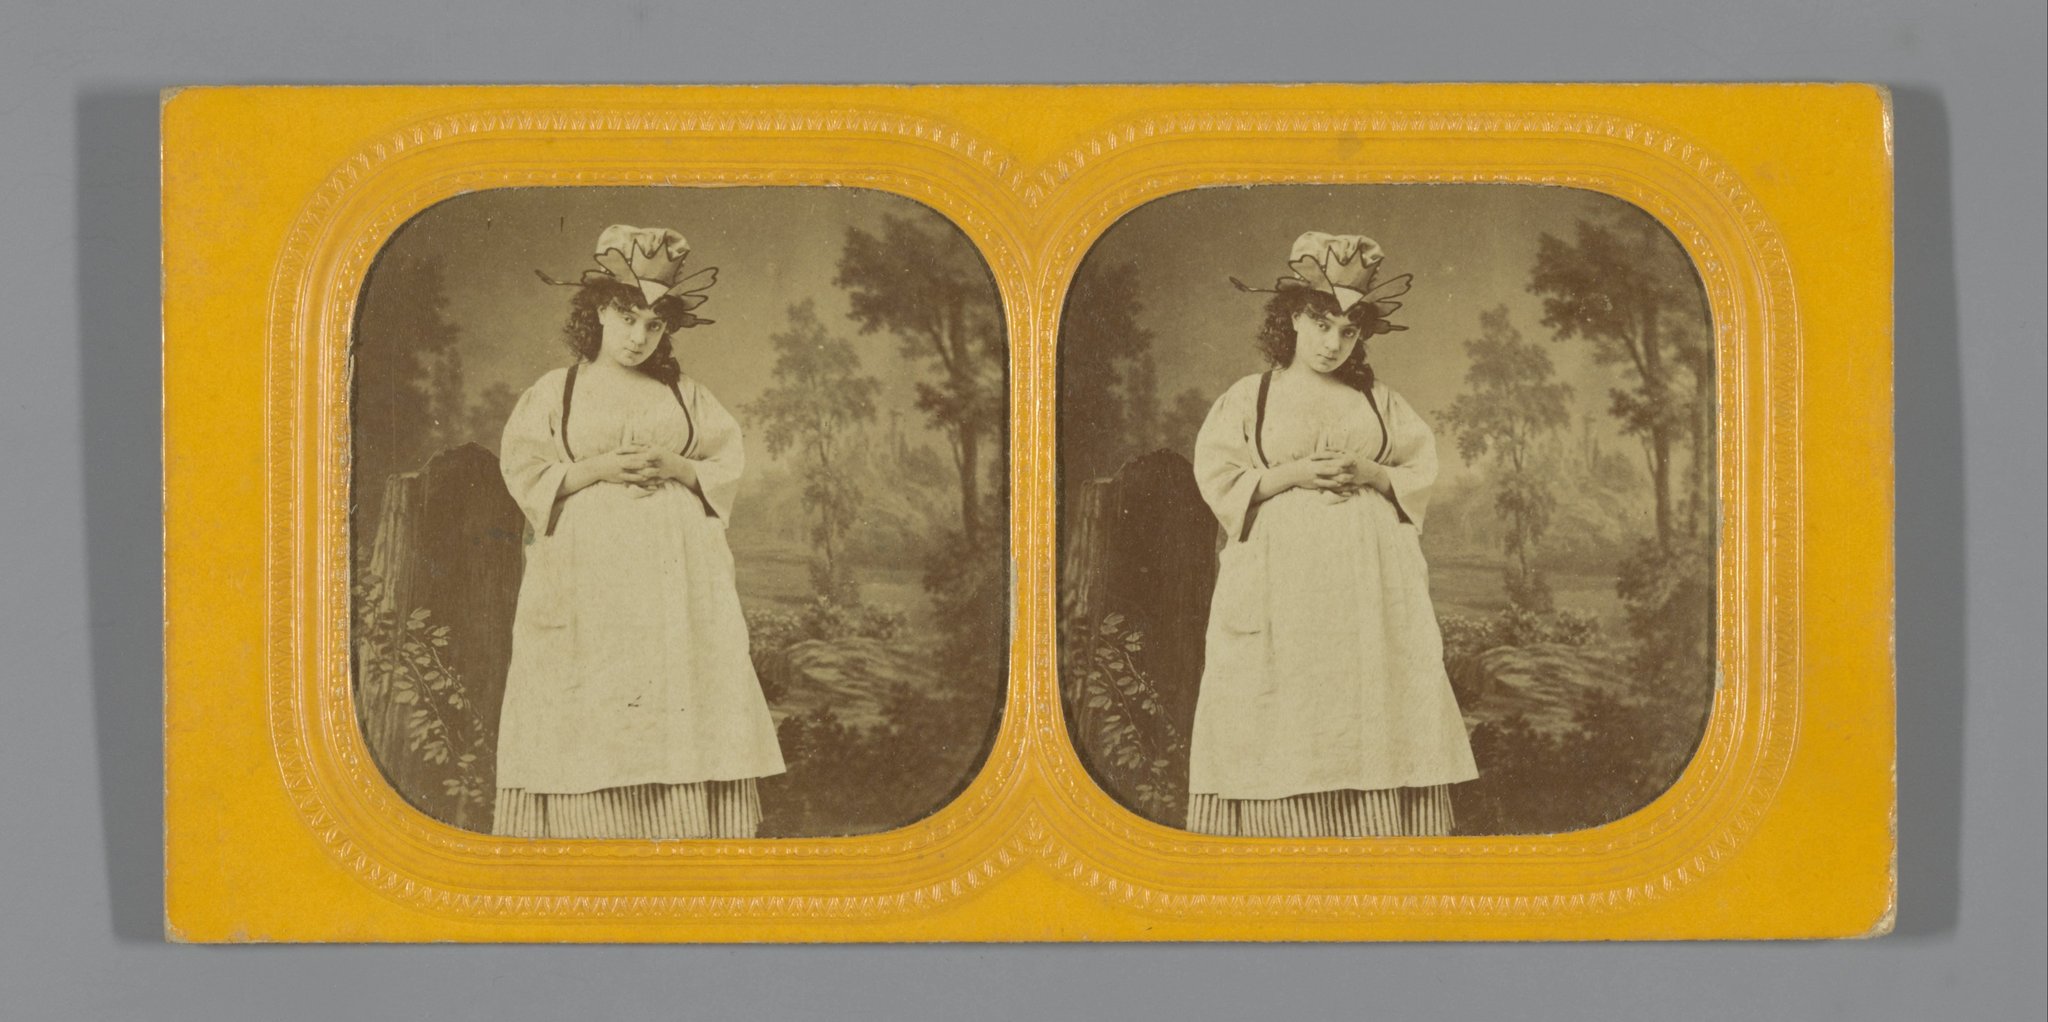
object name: tissue stereograph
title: Portret van een zwangere vrouw voor geschilderd decor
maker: Anonymous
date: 1855-1875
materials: cardboard, paper, photographic support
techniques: albumen print, hand coloring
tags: adult woman, anonymous historical person portrayed